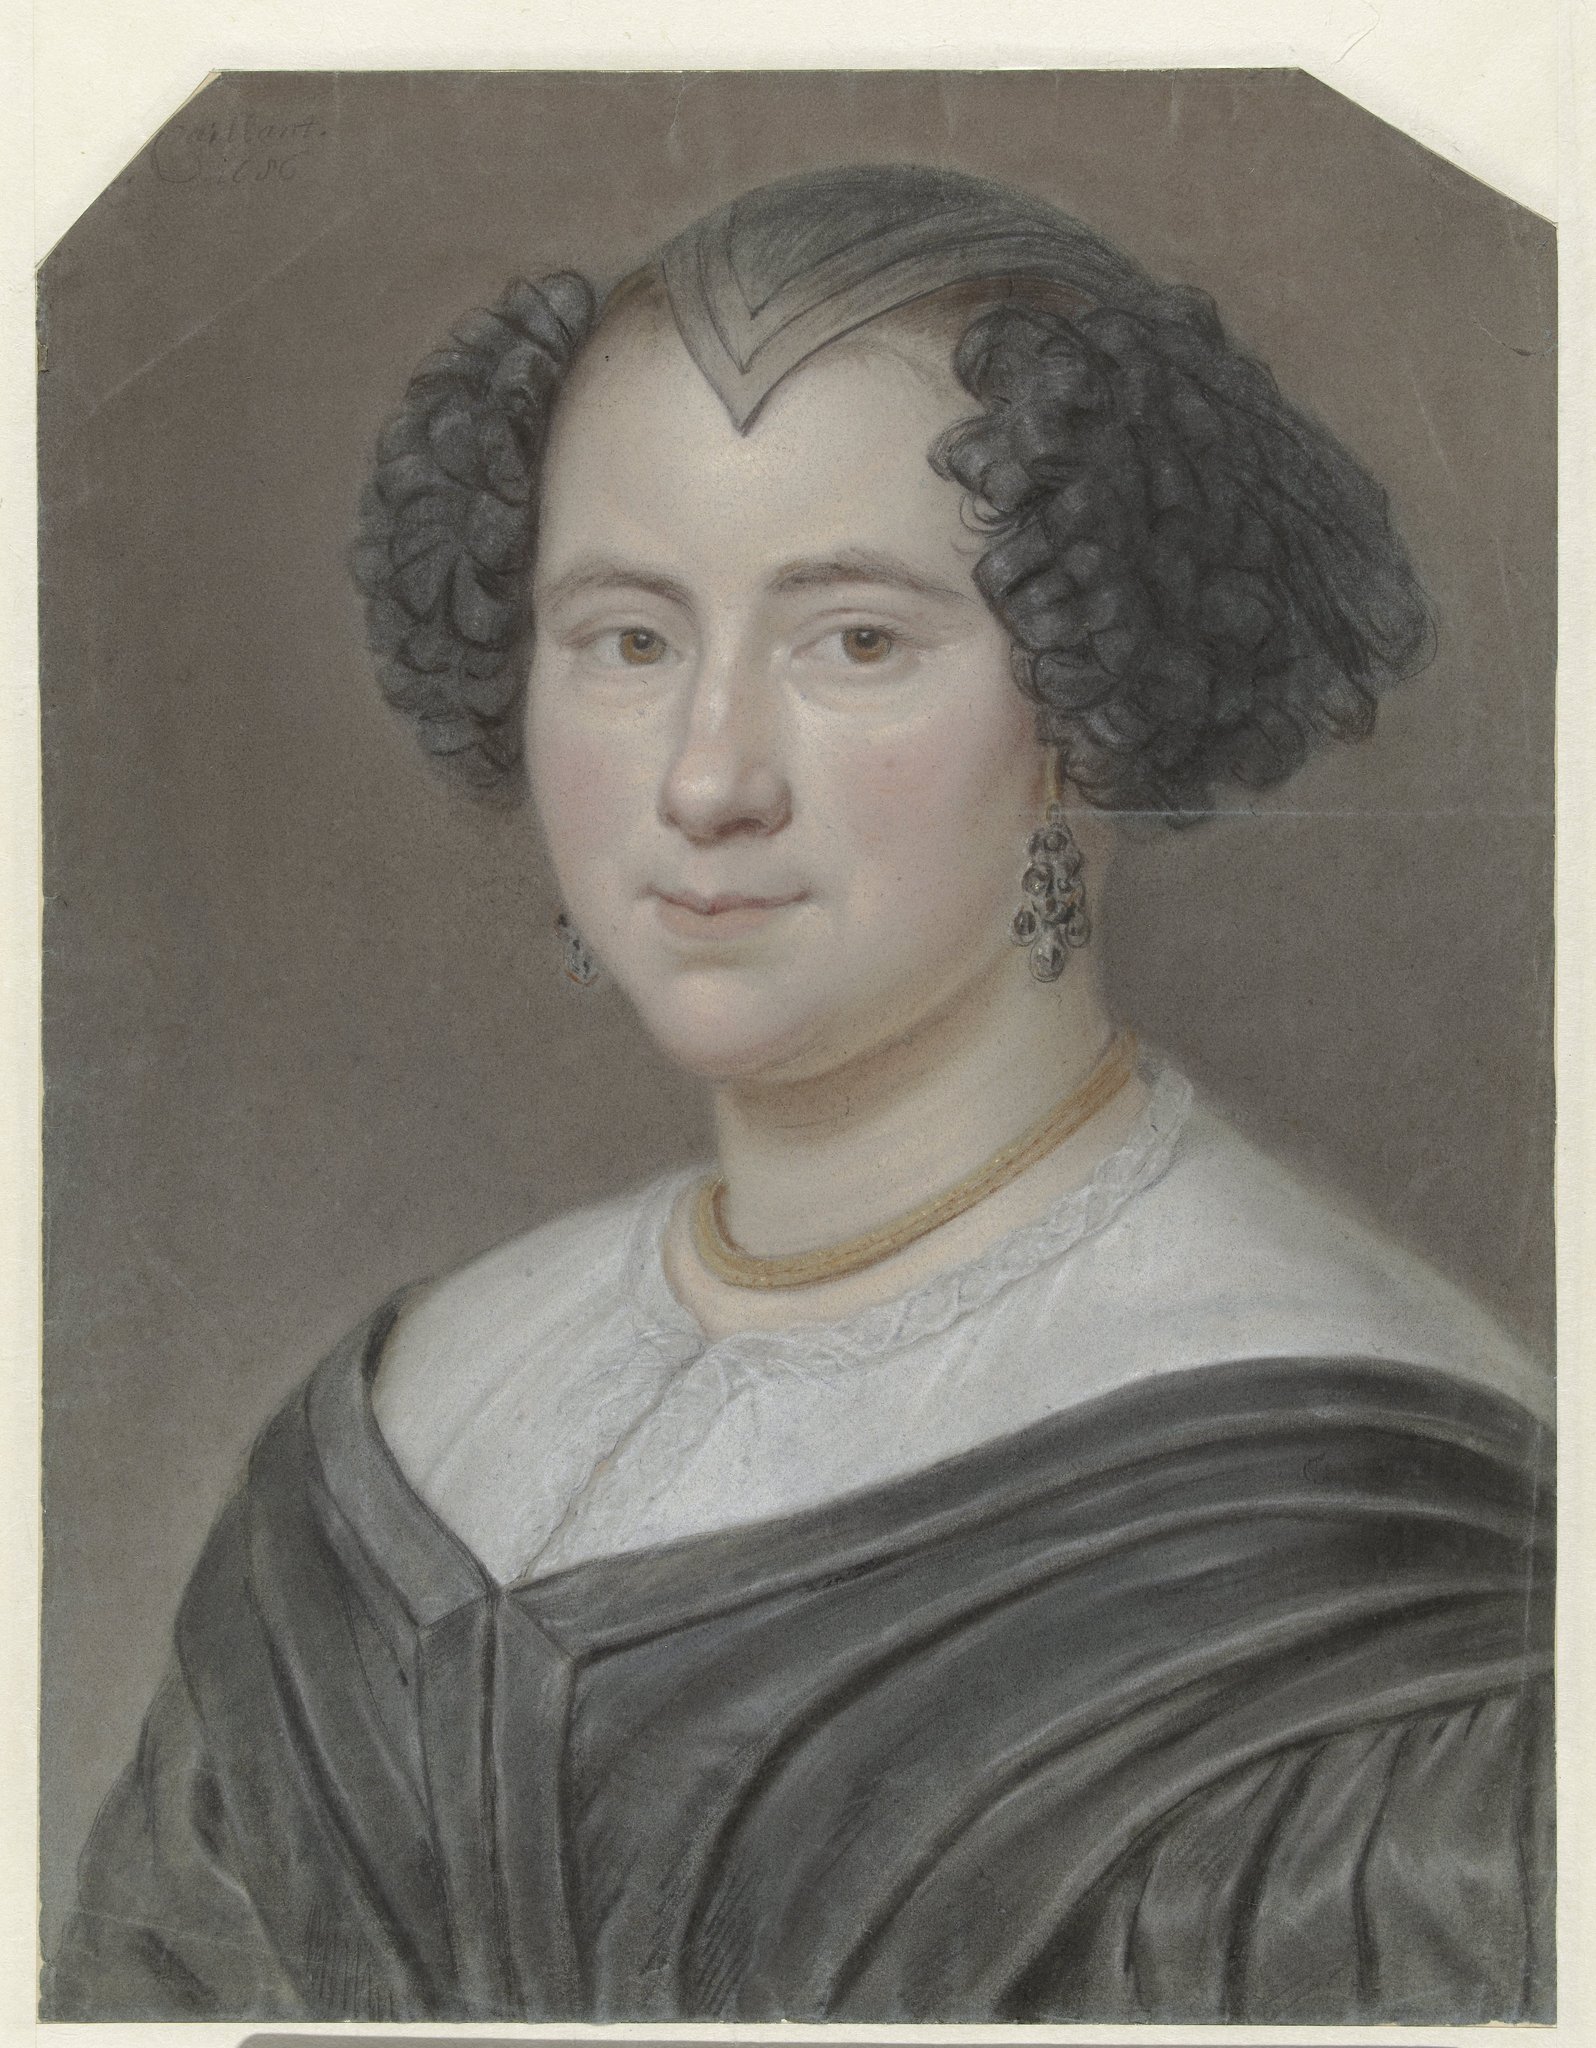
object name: drawing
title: Portret van een onbekende vrouw, buste, naar links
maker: bernard vaillant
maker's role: draughtsman, painter, print maker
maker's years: 1632-1698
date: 1686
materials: paper, pastel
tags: anonymous historical person portrayed alone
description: Pendant van 'Portret van onbekende man, buste, naar rechts'.